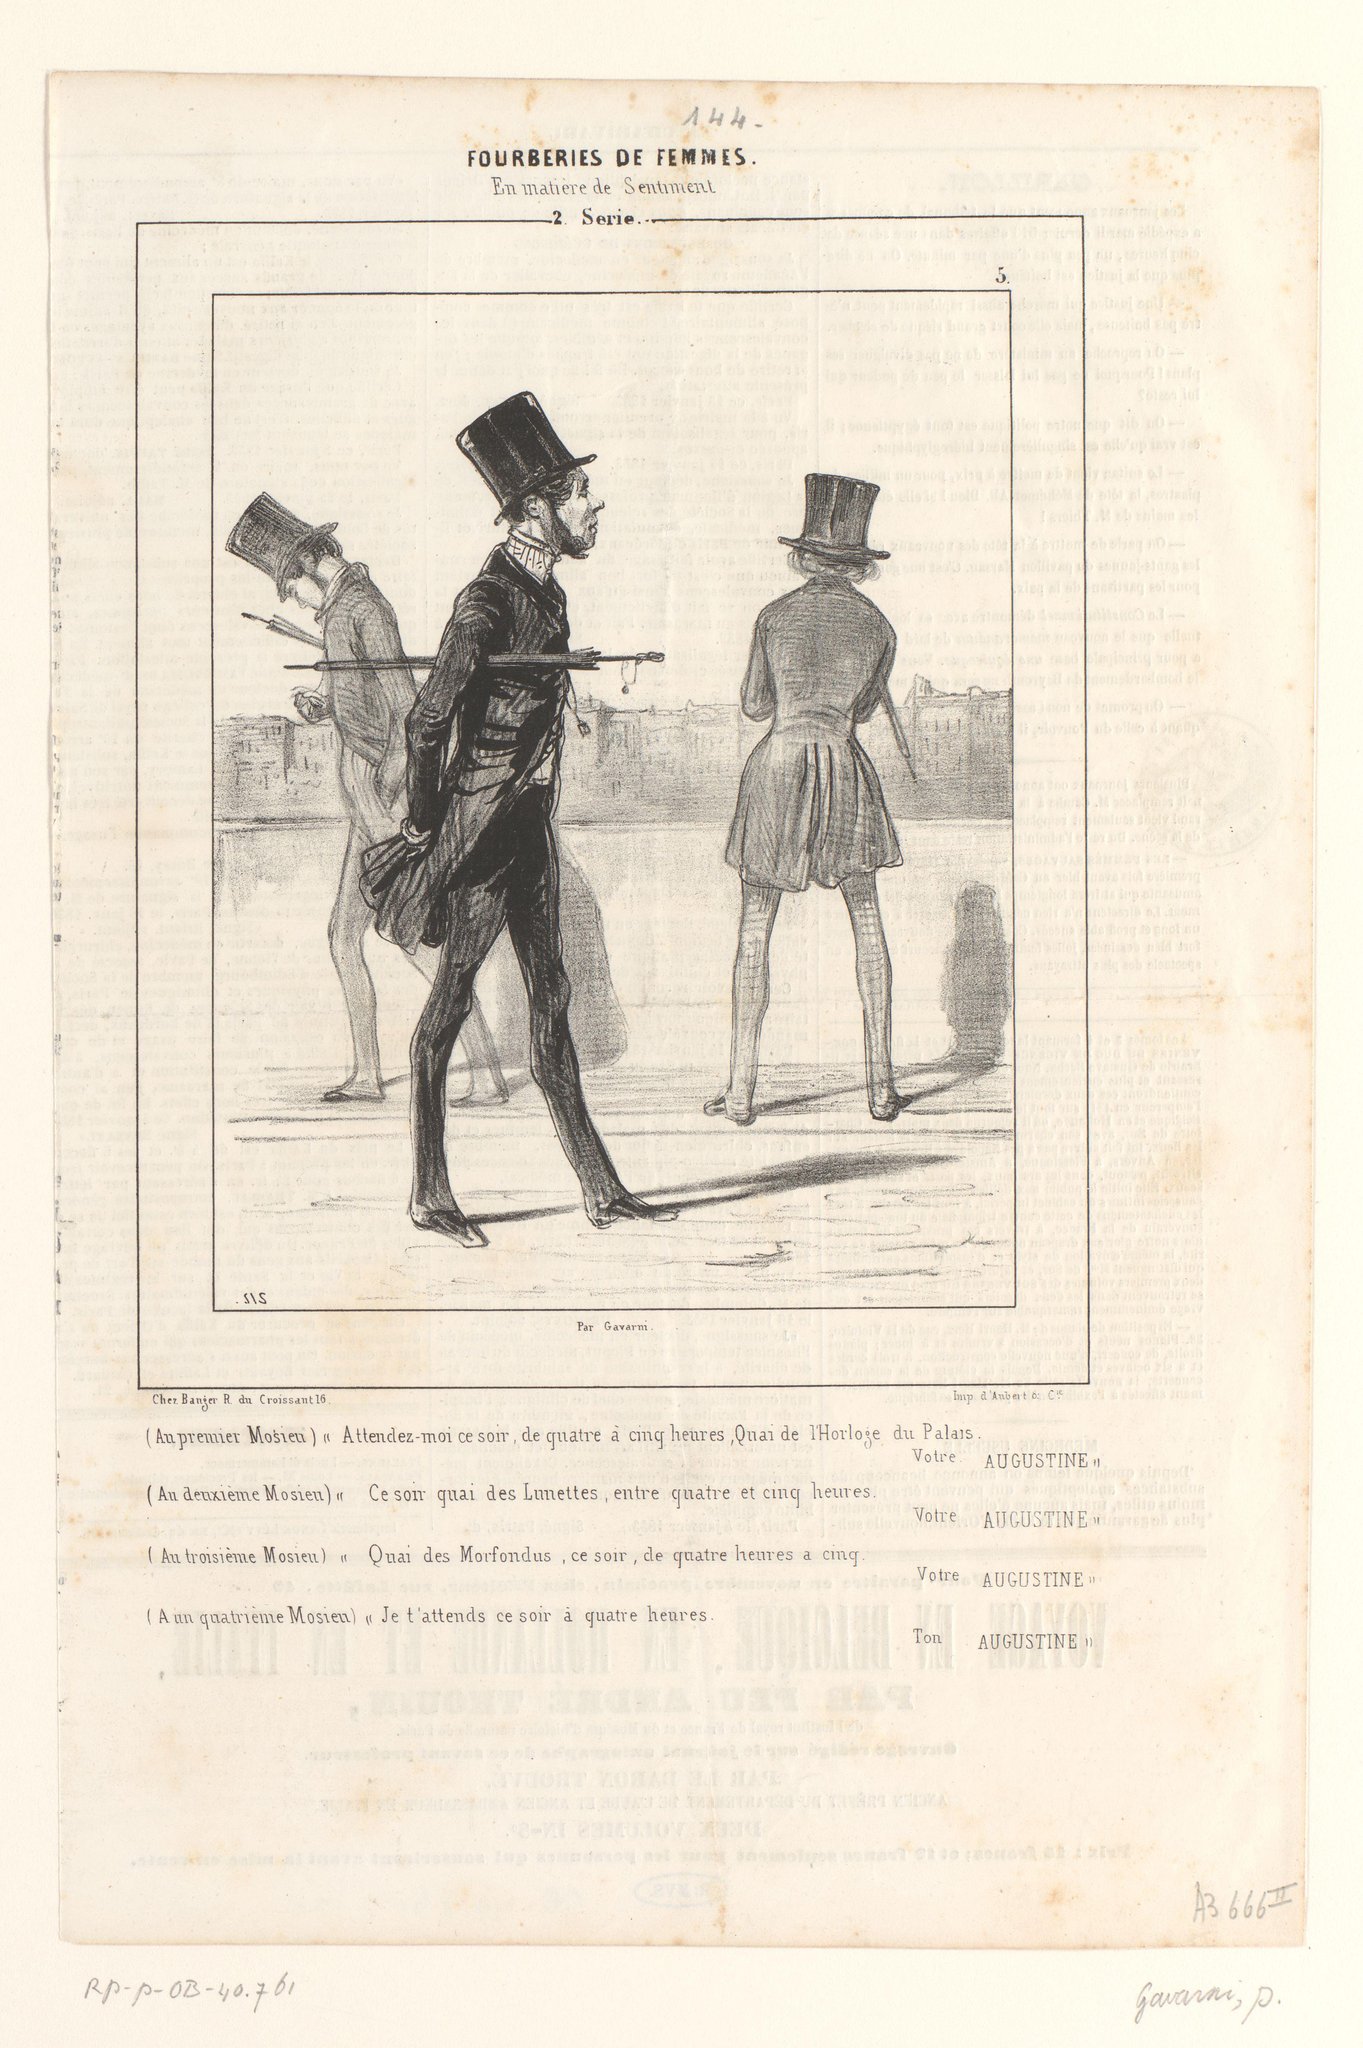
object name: cartoon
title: Fourberies de femmes en matière de sentiment (2)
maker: paul gavarni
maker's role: draughtsman, print maker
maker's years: 1804-1866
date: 1840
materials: paper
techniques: lithograph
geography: paris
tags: standing figure, the (difficult) choice ~ courting - cc - women making choice, one lover waiting for the other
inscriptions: collector's mark: Lugt 2228a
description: De vrouw houdt de mannen aan het lijntje: ze heeft met allemaal, zonder dat ze het van elkaar weten, op dezelfde tijd een afspraak gemaakt.